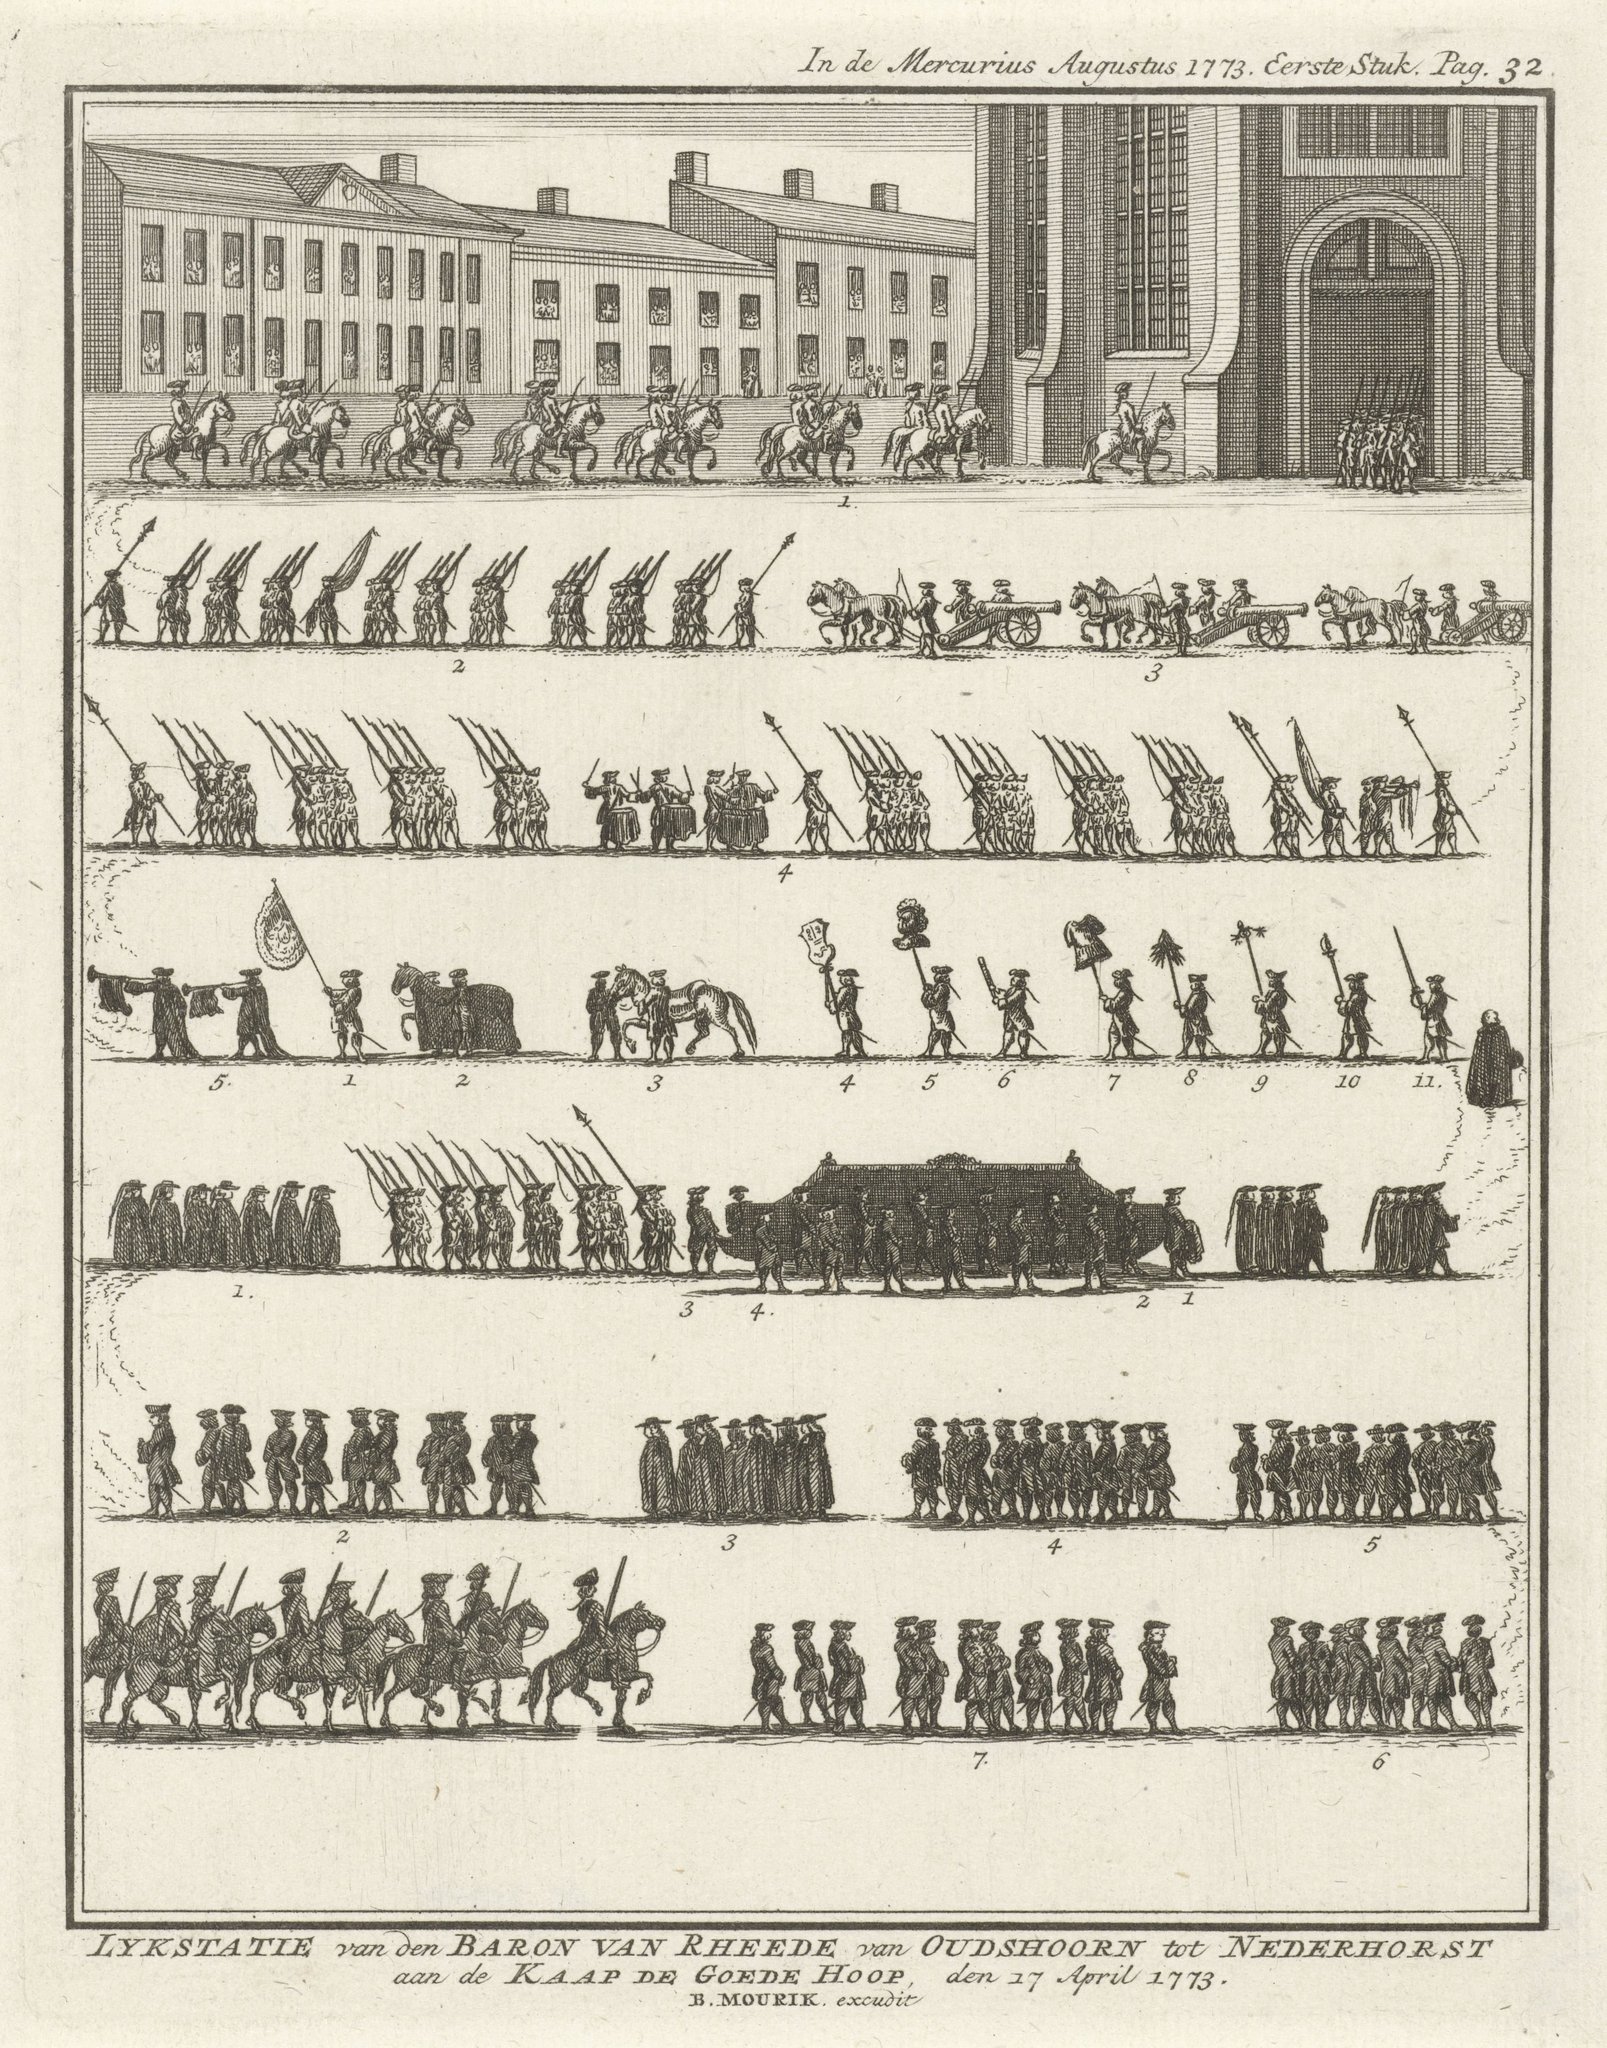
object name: print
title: Lykstatie van den Baron van Rheede van Oudshoorn tot Nederhorst aan de Kaap de Goede Hoop, den 17 April 1773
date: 1773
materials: paper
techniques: engraving, etching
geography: northern netherlands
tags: cortege, funeral procession, cape of good hope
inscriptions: collector's mark: Lugt 2228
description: Lijkstatie van Pieter baron van Rheede van Outshoorn tot Nederhorst. Overleden 23 januari 1773 aan boord van het VOC-schip Asia, begraven op 17 april 1773 in de kerk van Kaap de Goede Hoop. De begrafenisstoet slingert in zeven banen naar de ingang van de kerk.